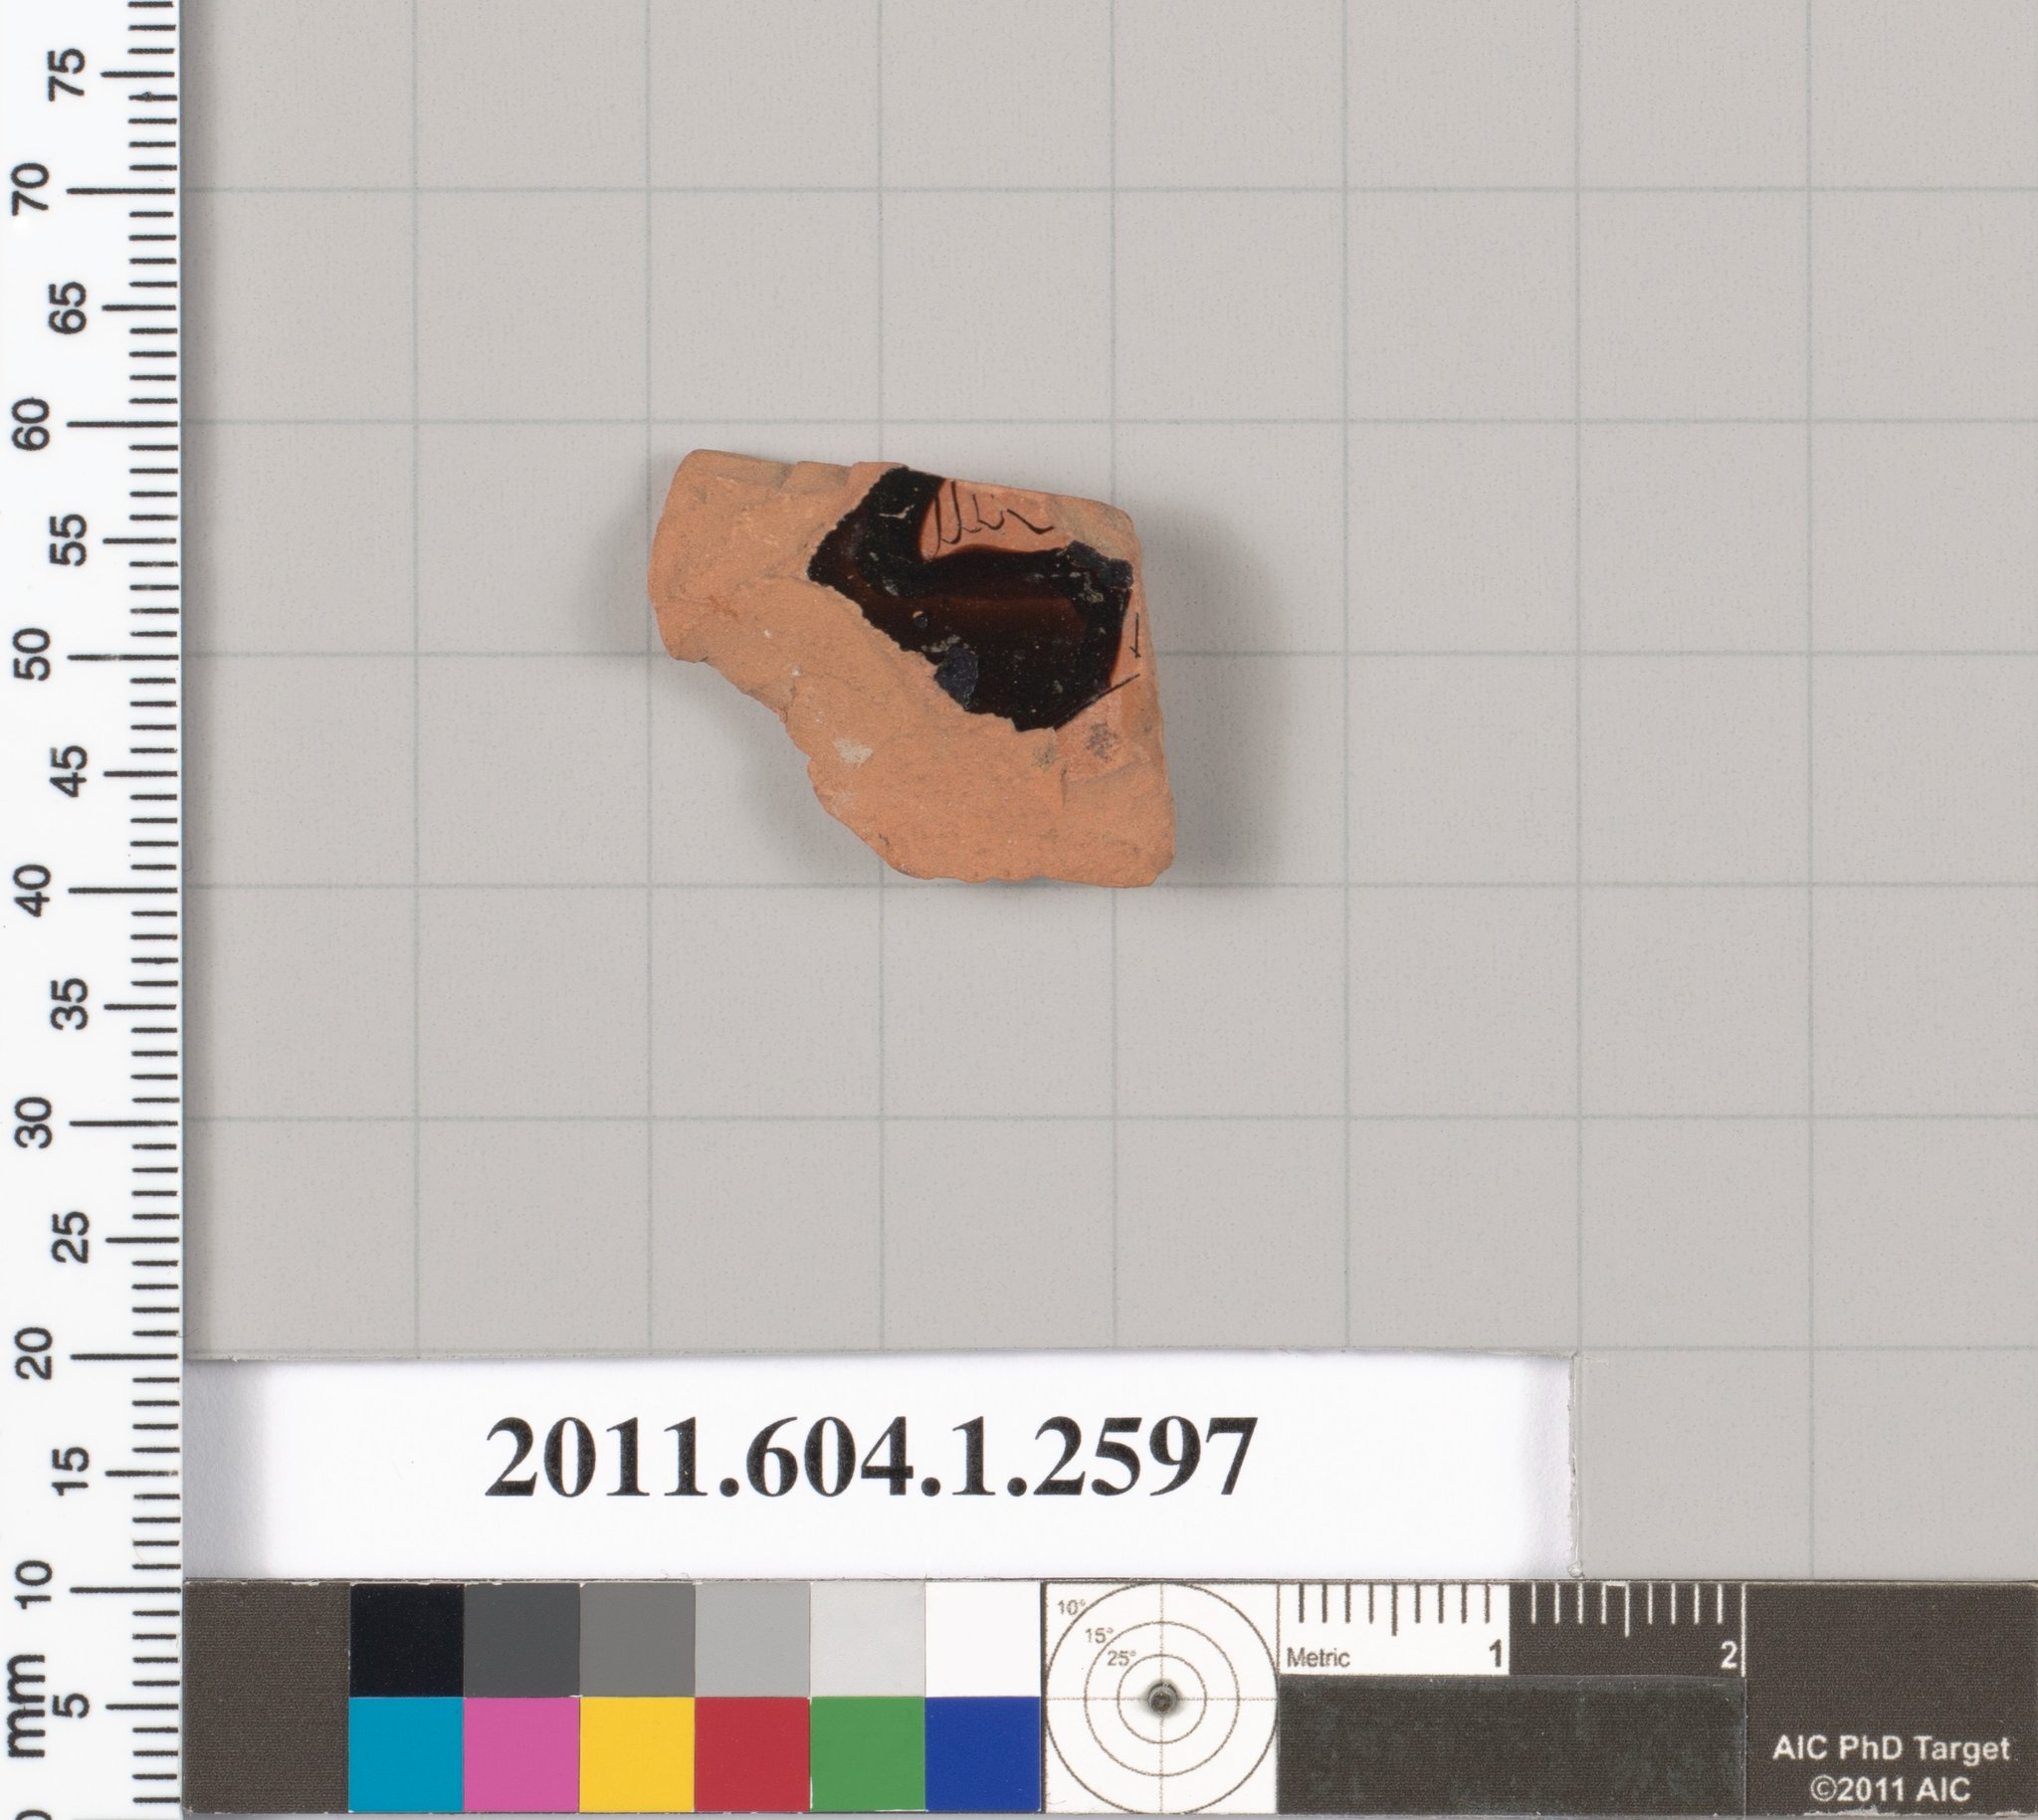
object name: kylix fragment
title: Terracotta fragment of a kylix (drinking cup)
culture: greek, attic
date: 475-451 BCE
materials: terracotta